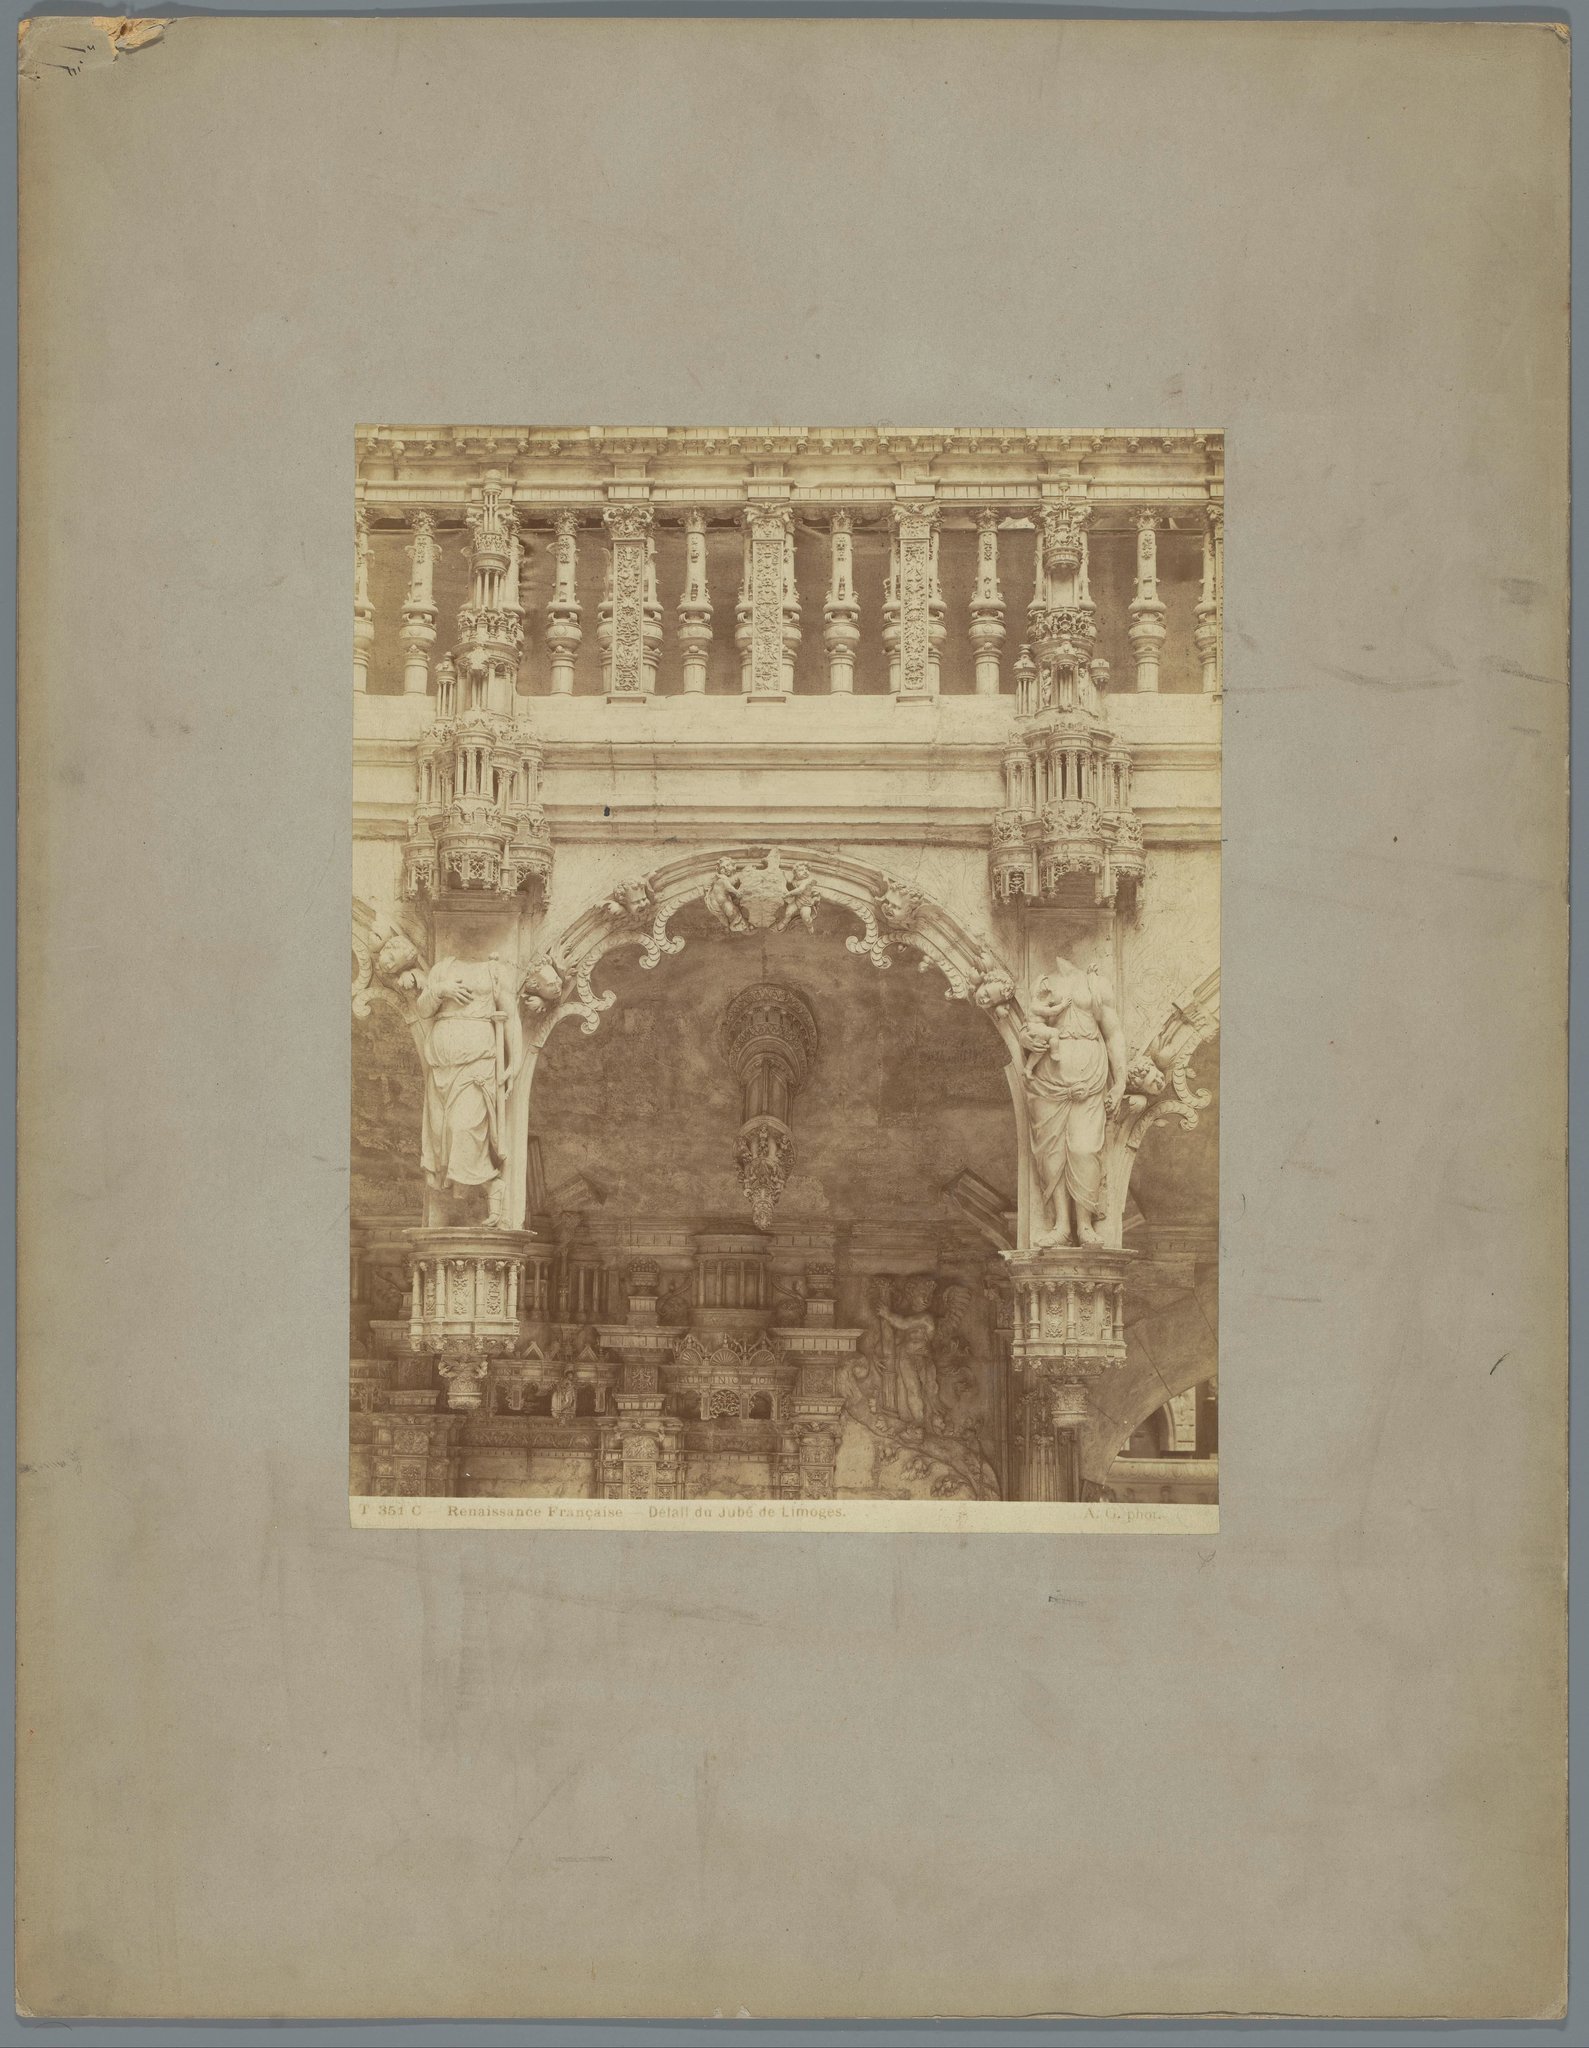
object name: photograph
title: Detail van het doksaal in de Kathedraal van Limoges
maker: adolphe giraudon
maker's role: publisher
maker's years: 1849-1929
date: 1875-1900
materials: cardboard, photographic support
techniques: albumen print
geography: limoges cathedral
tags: rood-screen, choir-screen; iconostasis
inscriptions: number: ‘T 351 C’, collector's mark: Lugt 3937